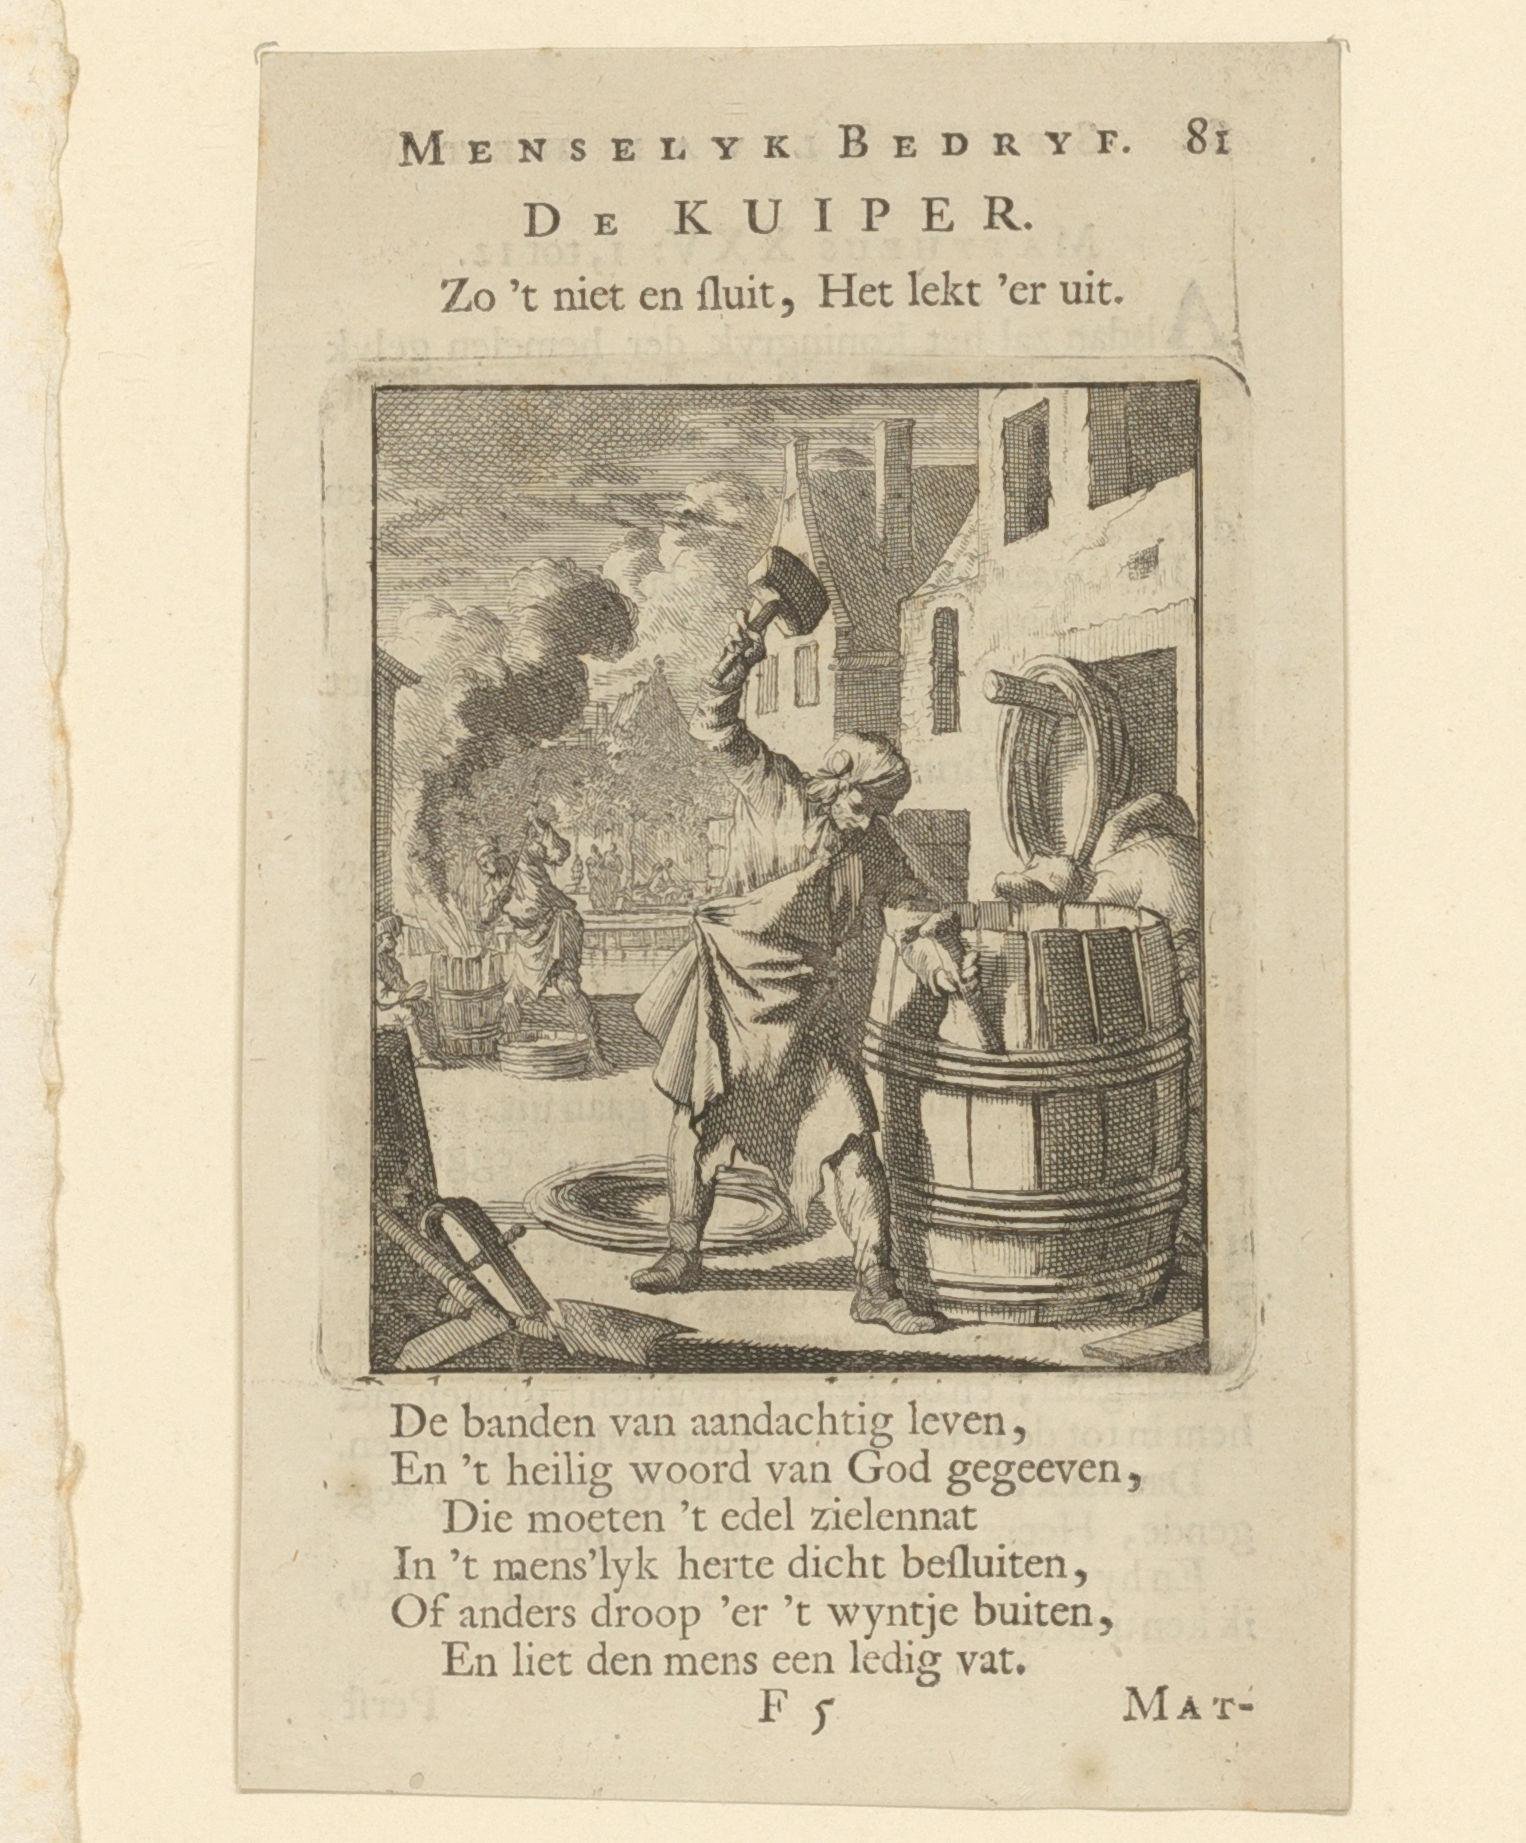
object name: print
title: De Kuiper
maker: cornelis van der sys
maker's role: publisher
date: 1718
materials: paper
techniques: etching, letterpress printing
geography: amsterdam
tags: handicrafts, craftsman at work, wooden container: barrel, cask, bucket, handicrafts ~ wood, timber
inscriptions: collector's mark: Lugt 1641, stamp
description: Prent oorspronkelijk verschenen in de 100-delige serie beroepsprenten van Jan en Caspar Luyken, getiteld: Het menselyk bedryf. S.l.s.n., 1694 (eerste druk). Daarna is de titel en het vers afgesneden. De prenten in diverse publicaties verschenen en gekopieerd. Huidige staat uit: Luyken, Jan en Caspar. Spiegel van het menselyk bedryf (...). Amsterdam: Cornelis van der Sys, 1718, p. 81. Prent waarschijnlijk ook gebruikt in eerdere (1704) en latere (1730, 1749, 1767) publicaties.